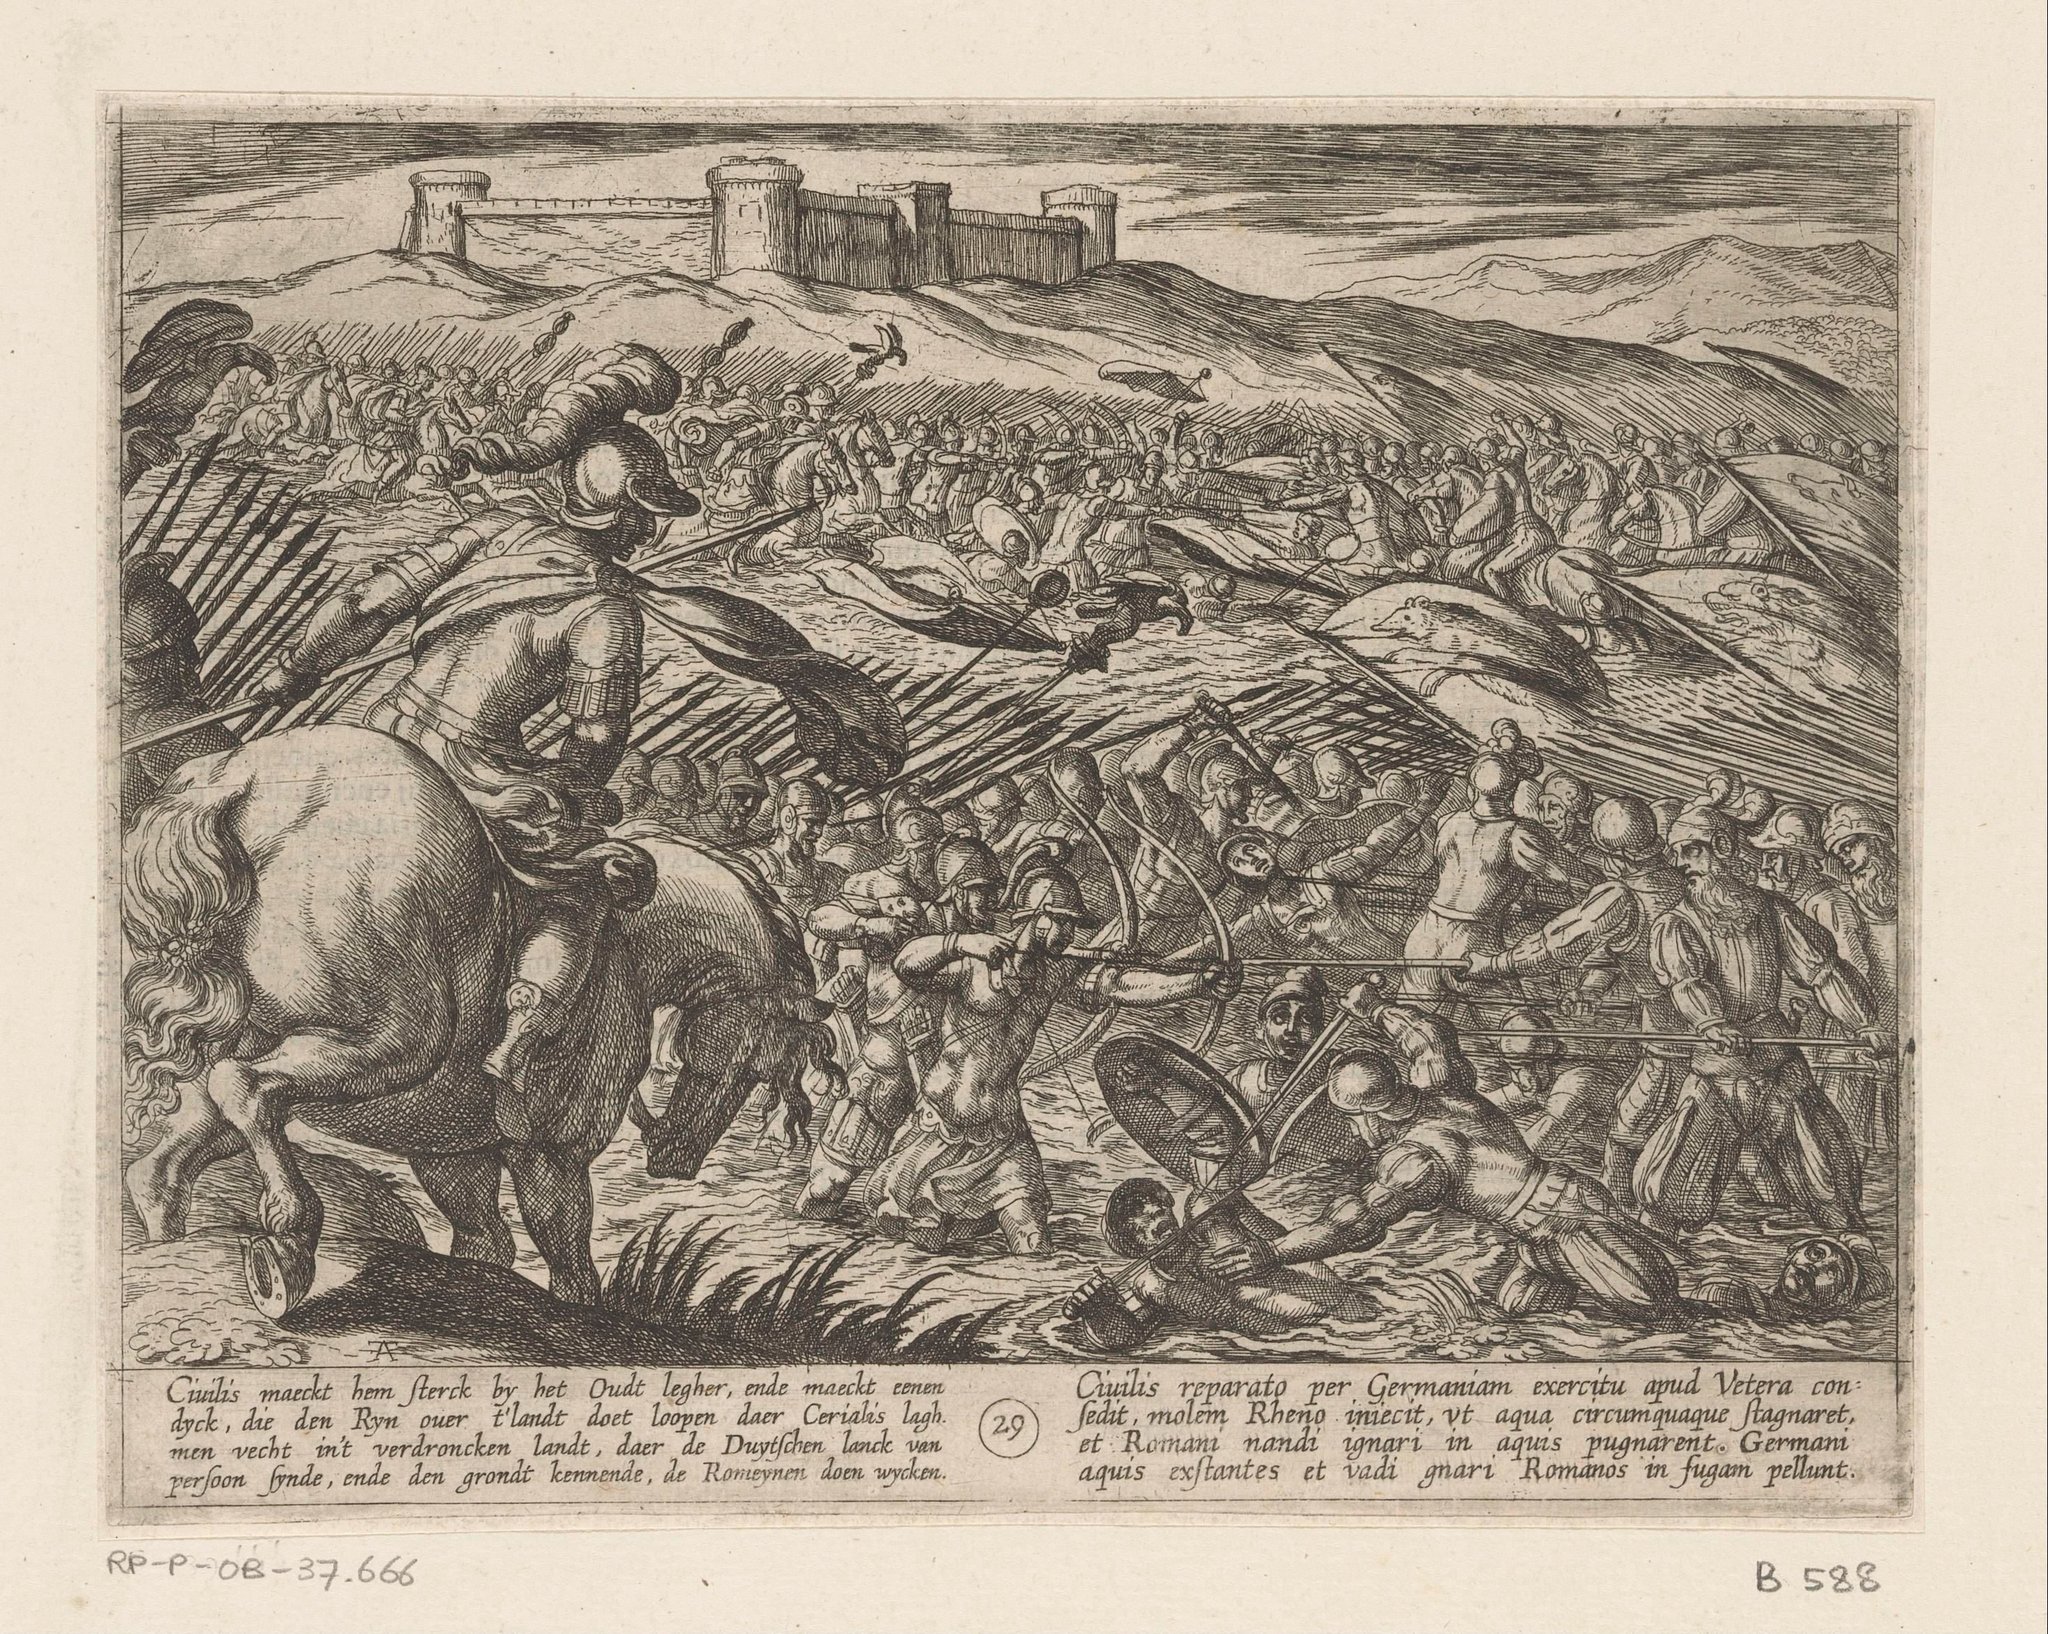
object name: print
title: De Bataafse oorlogen tegen de Romeinen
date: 1611-1612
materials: paper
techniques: etching, letterpress printing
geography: italy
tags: flood, high tide, battle, the soldier; the soldier's life, (story of) julius claudius civilis, extinct, 'historical' peoples (with name)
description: Julius Civilis zet het land tijdens een strijd tegen de Romeinen onder water met behulp van dijken. Op de achtergrond een fort. Onderschrift in het Nederlands en in het Latijn.